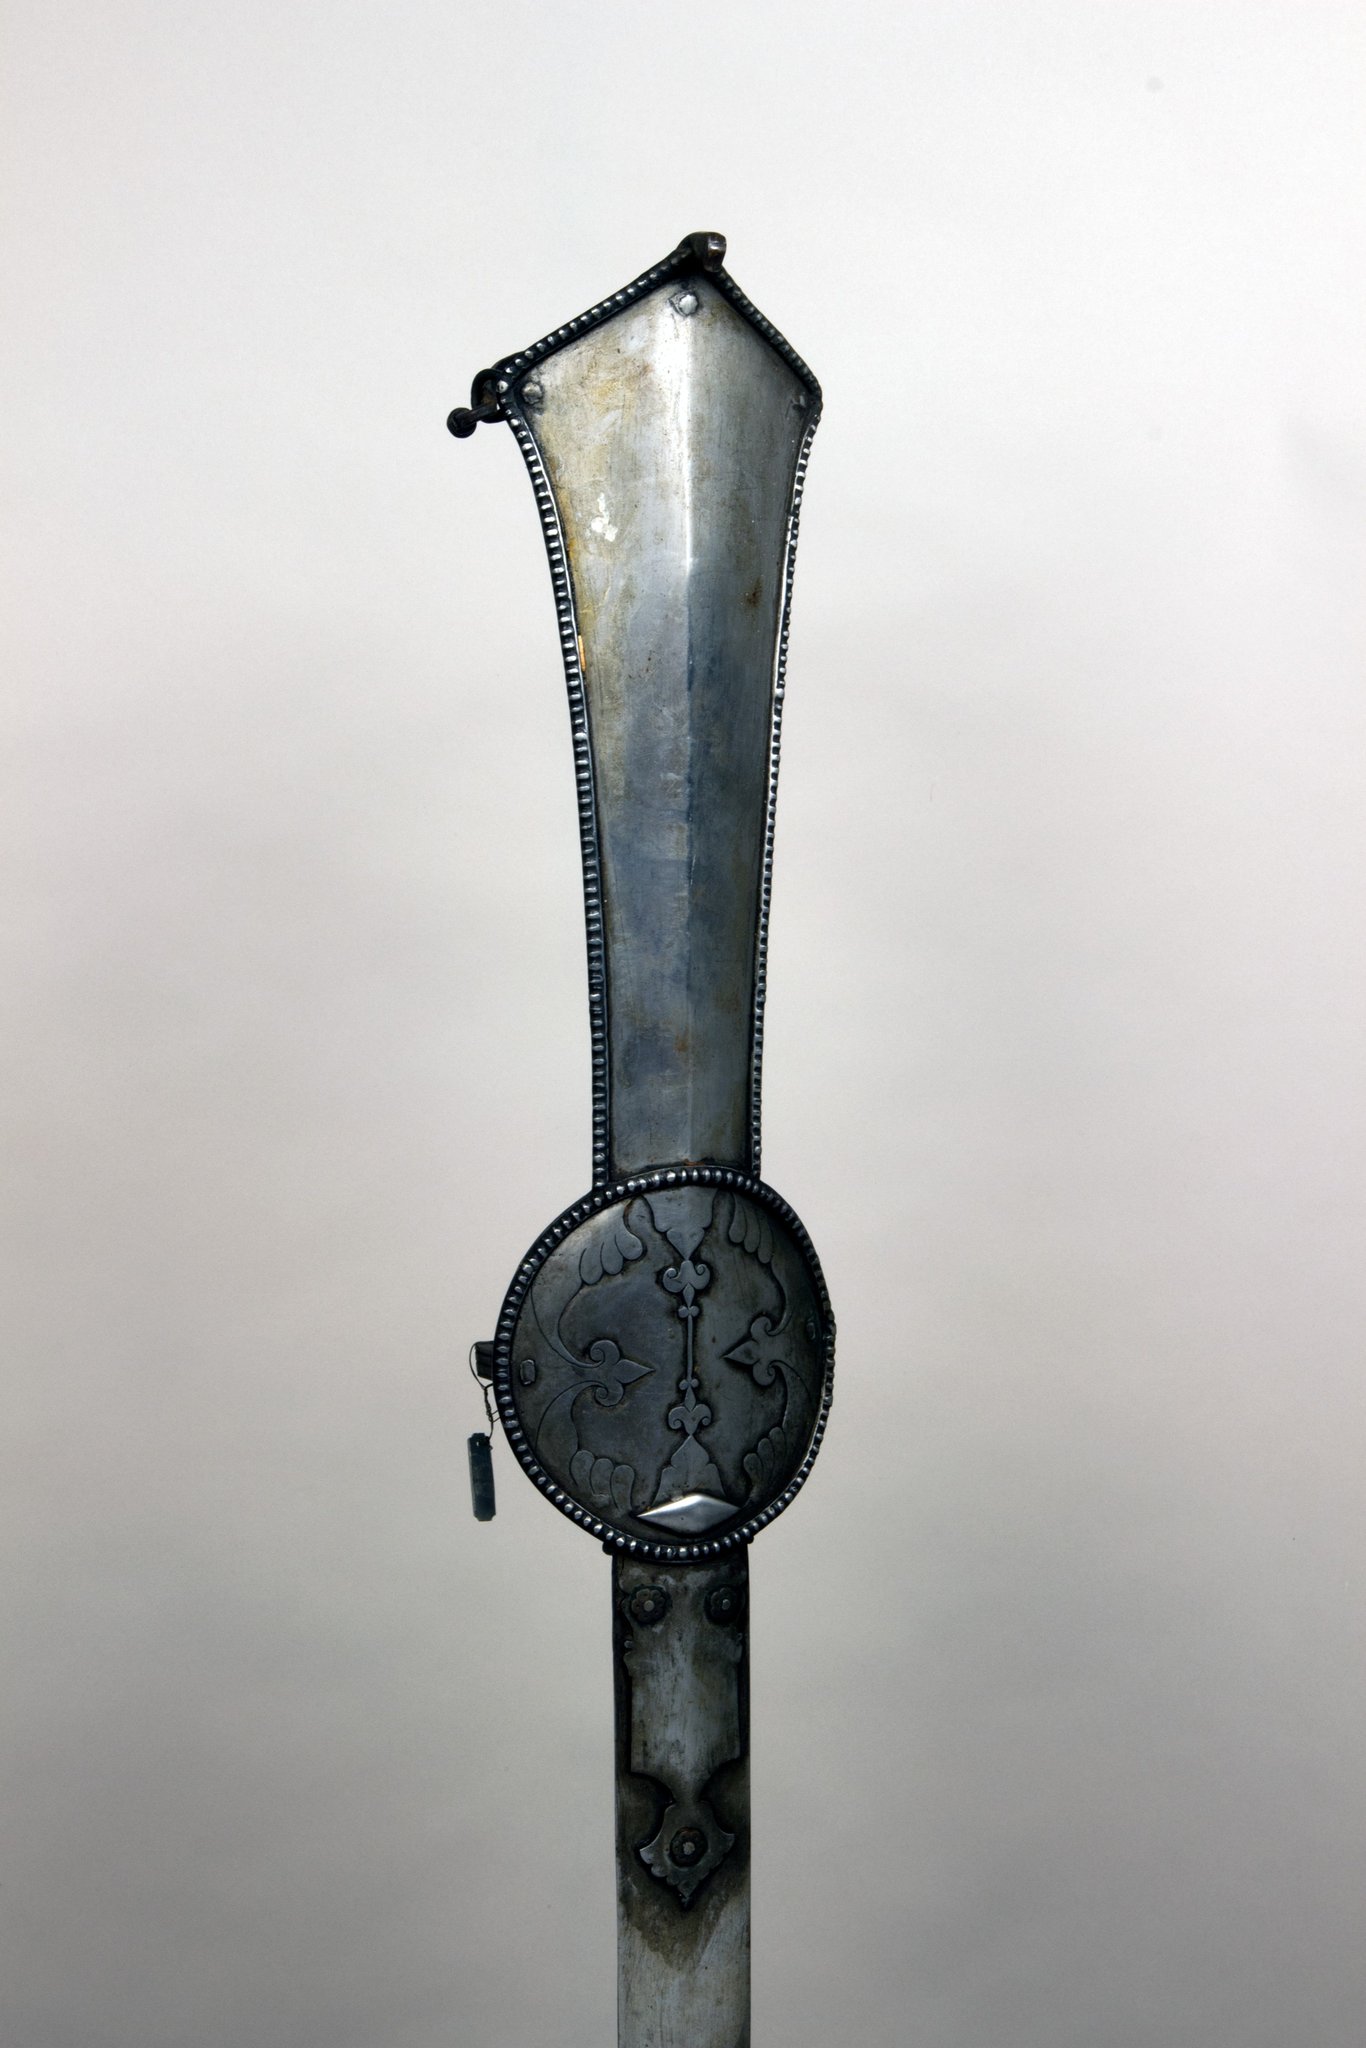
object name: gauntlet sword pata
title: Gauntlet Sword (Pata)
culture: indian, south indian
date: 1701-1800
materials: steel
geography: south india